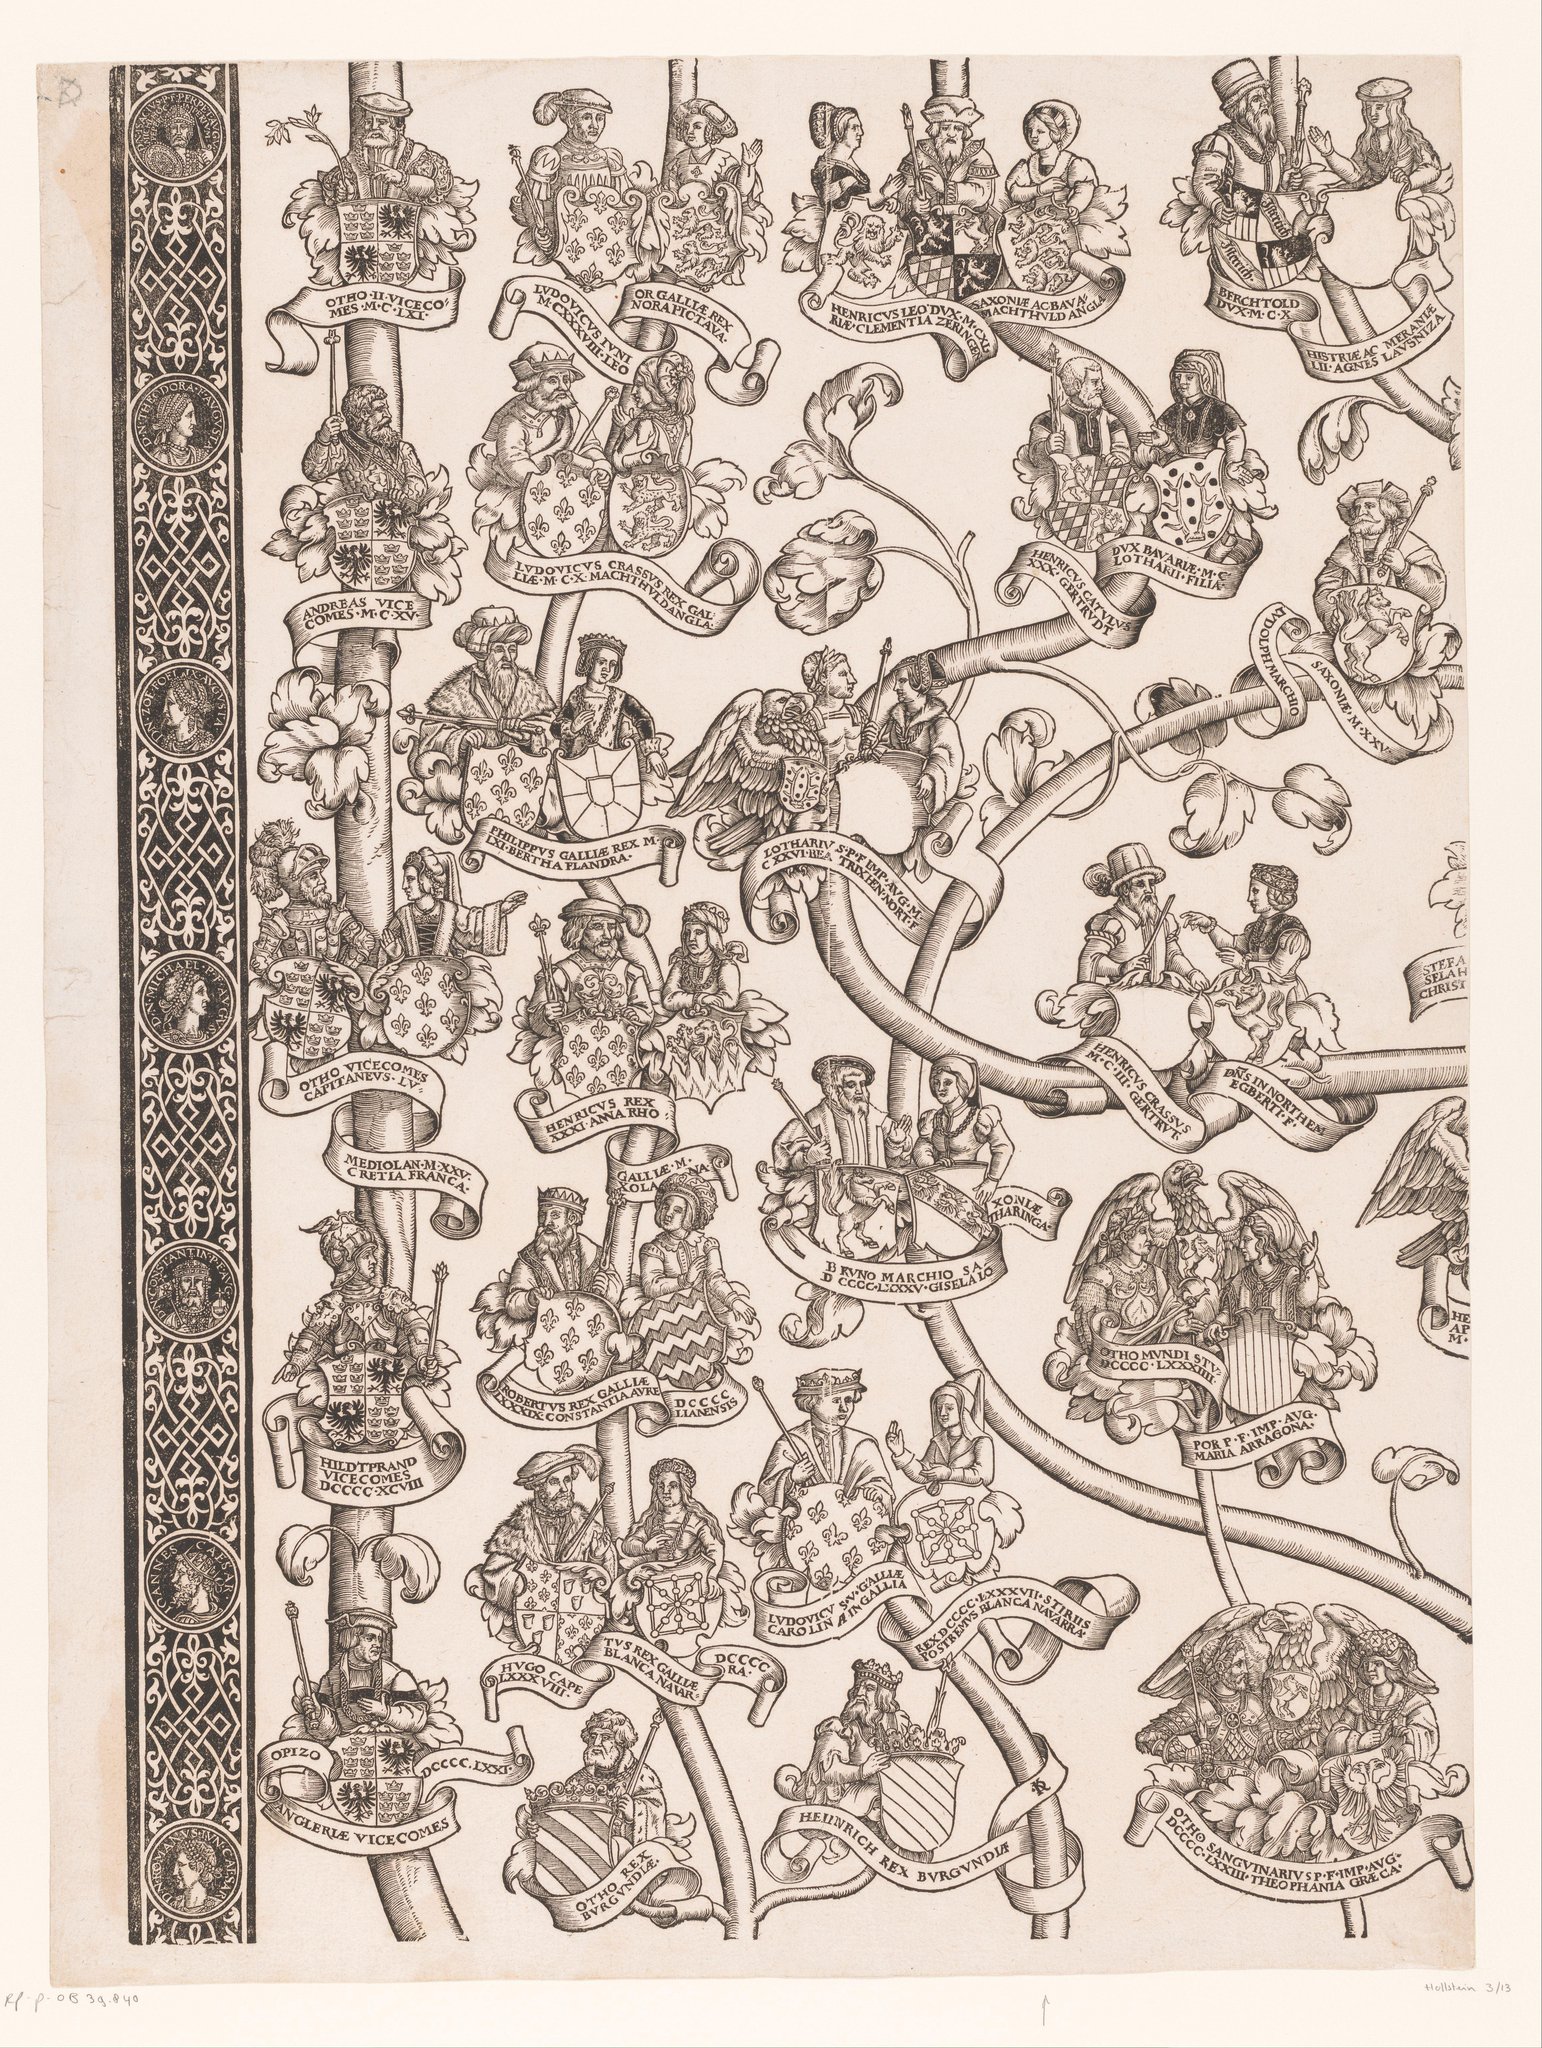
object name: print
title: Stamboom van Frederik en Ottheinrich van Palts-Neuburg (plaat 13)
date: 1535-1594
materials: paper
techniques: letterpress printing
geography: basel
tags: amberg, earl, family lineage, pedigree, genealogical tree or table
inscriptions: collector's mark: Lugt 240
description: Blad 13 van een stamboom bestaande uit 21 bladen, gedrukt van 42 blokken.